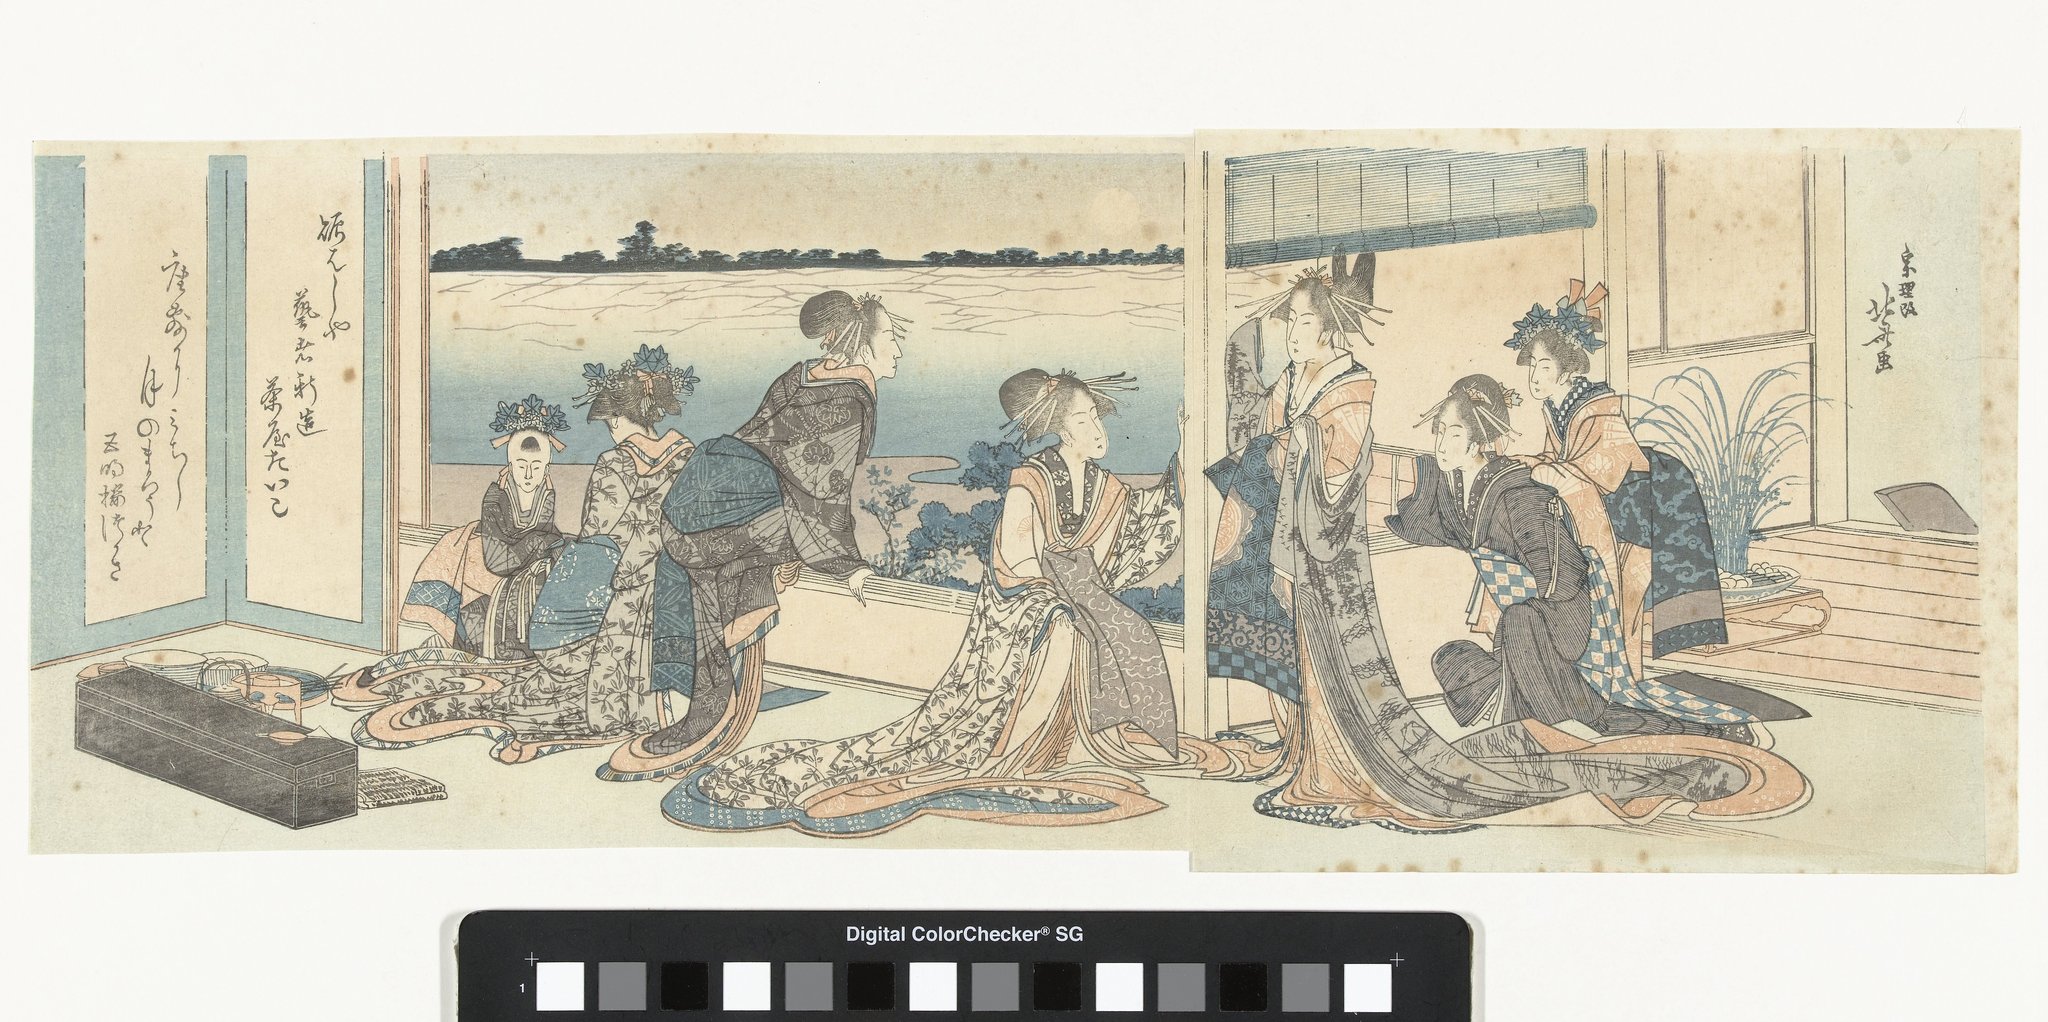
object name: print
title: Courtisanes kijkend naar de herfstmaan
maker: katsushika hokusai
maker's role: draughtsman, print maker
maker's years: 1760-1849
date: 1800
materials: paper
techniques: woodcut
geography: japan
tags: courtesan, hetaera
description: Een surimono is een luxe uitgevoerde prent waarop beeld met één of meerdere gedichten gecombineerd is. Bij het drukken van een surimono werd vaak gebruik gemaakt van dikker papier, blinddruk en metaal pigmenten, zoals koper- en zilverpoeder. De prenten werden vaak in opdracht van dichters gemaakt en als exclusief geschenk aan vrienden en relaties gegeven.